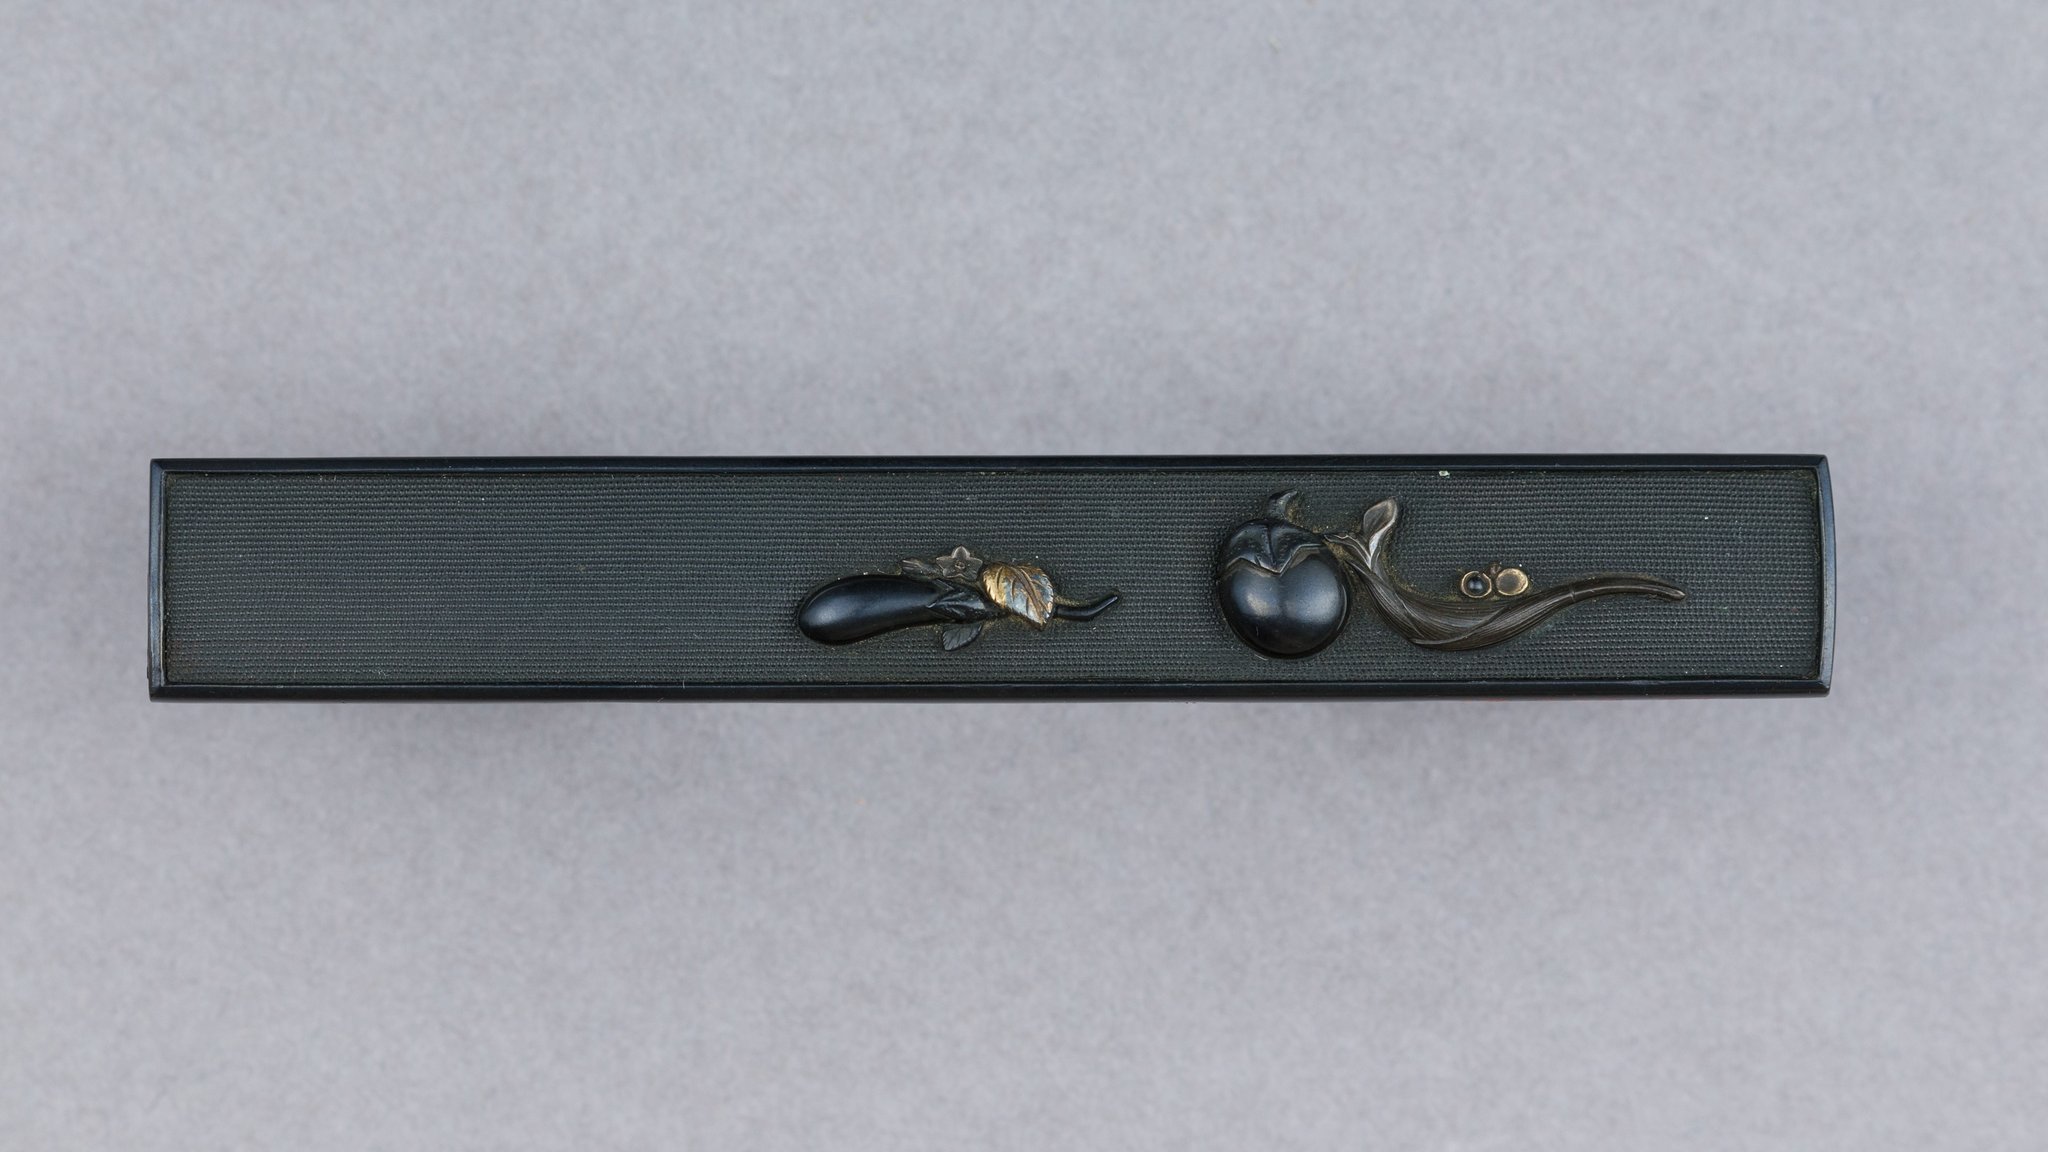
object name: knife handle kozuka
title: Knife Handle (Kozuka)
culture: japanese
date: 1701-1800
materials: gold alloy, silver alloy, gold, silver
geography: japan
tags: eggplants